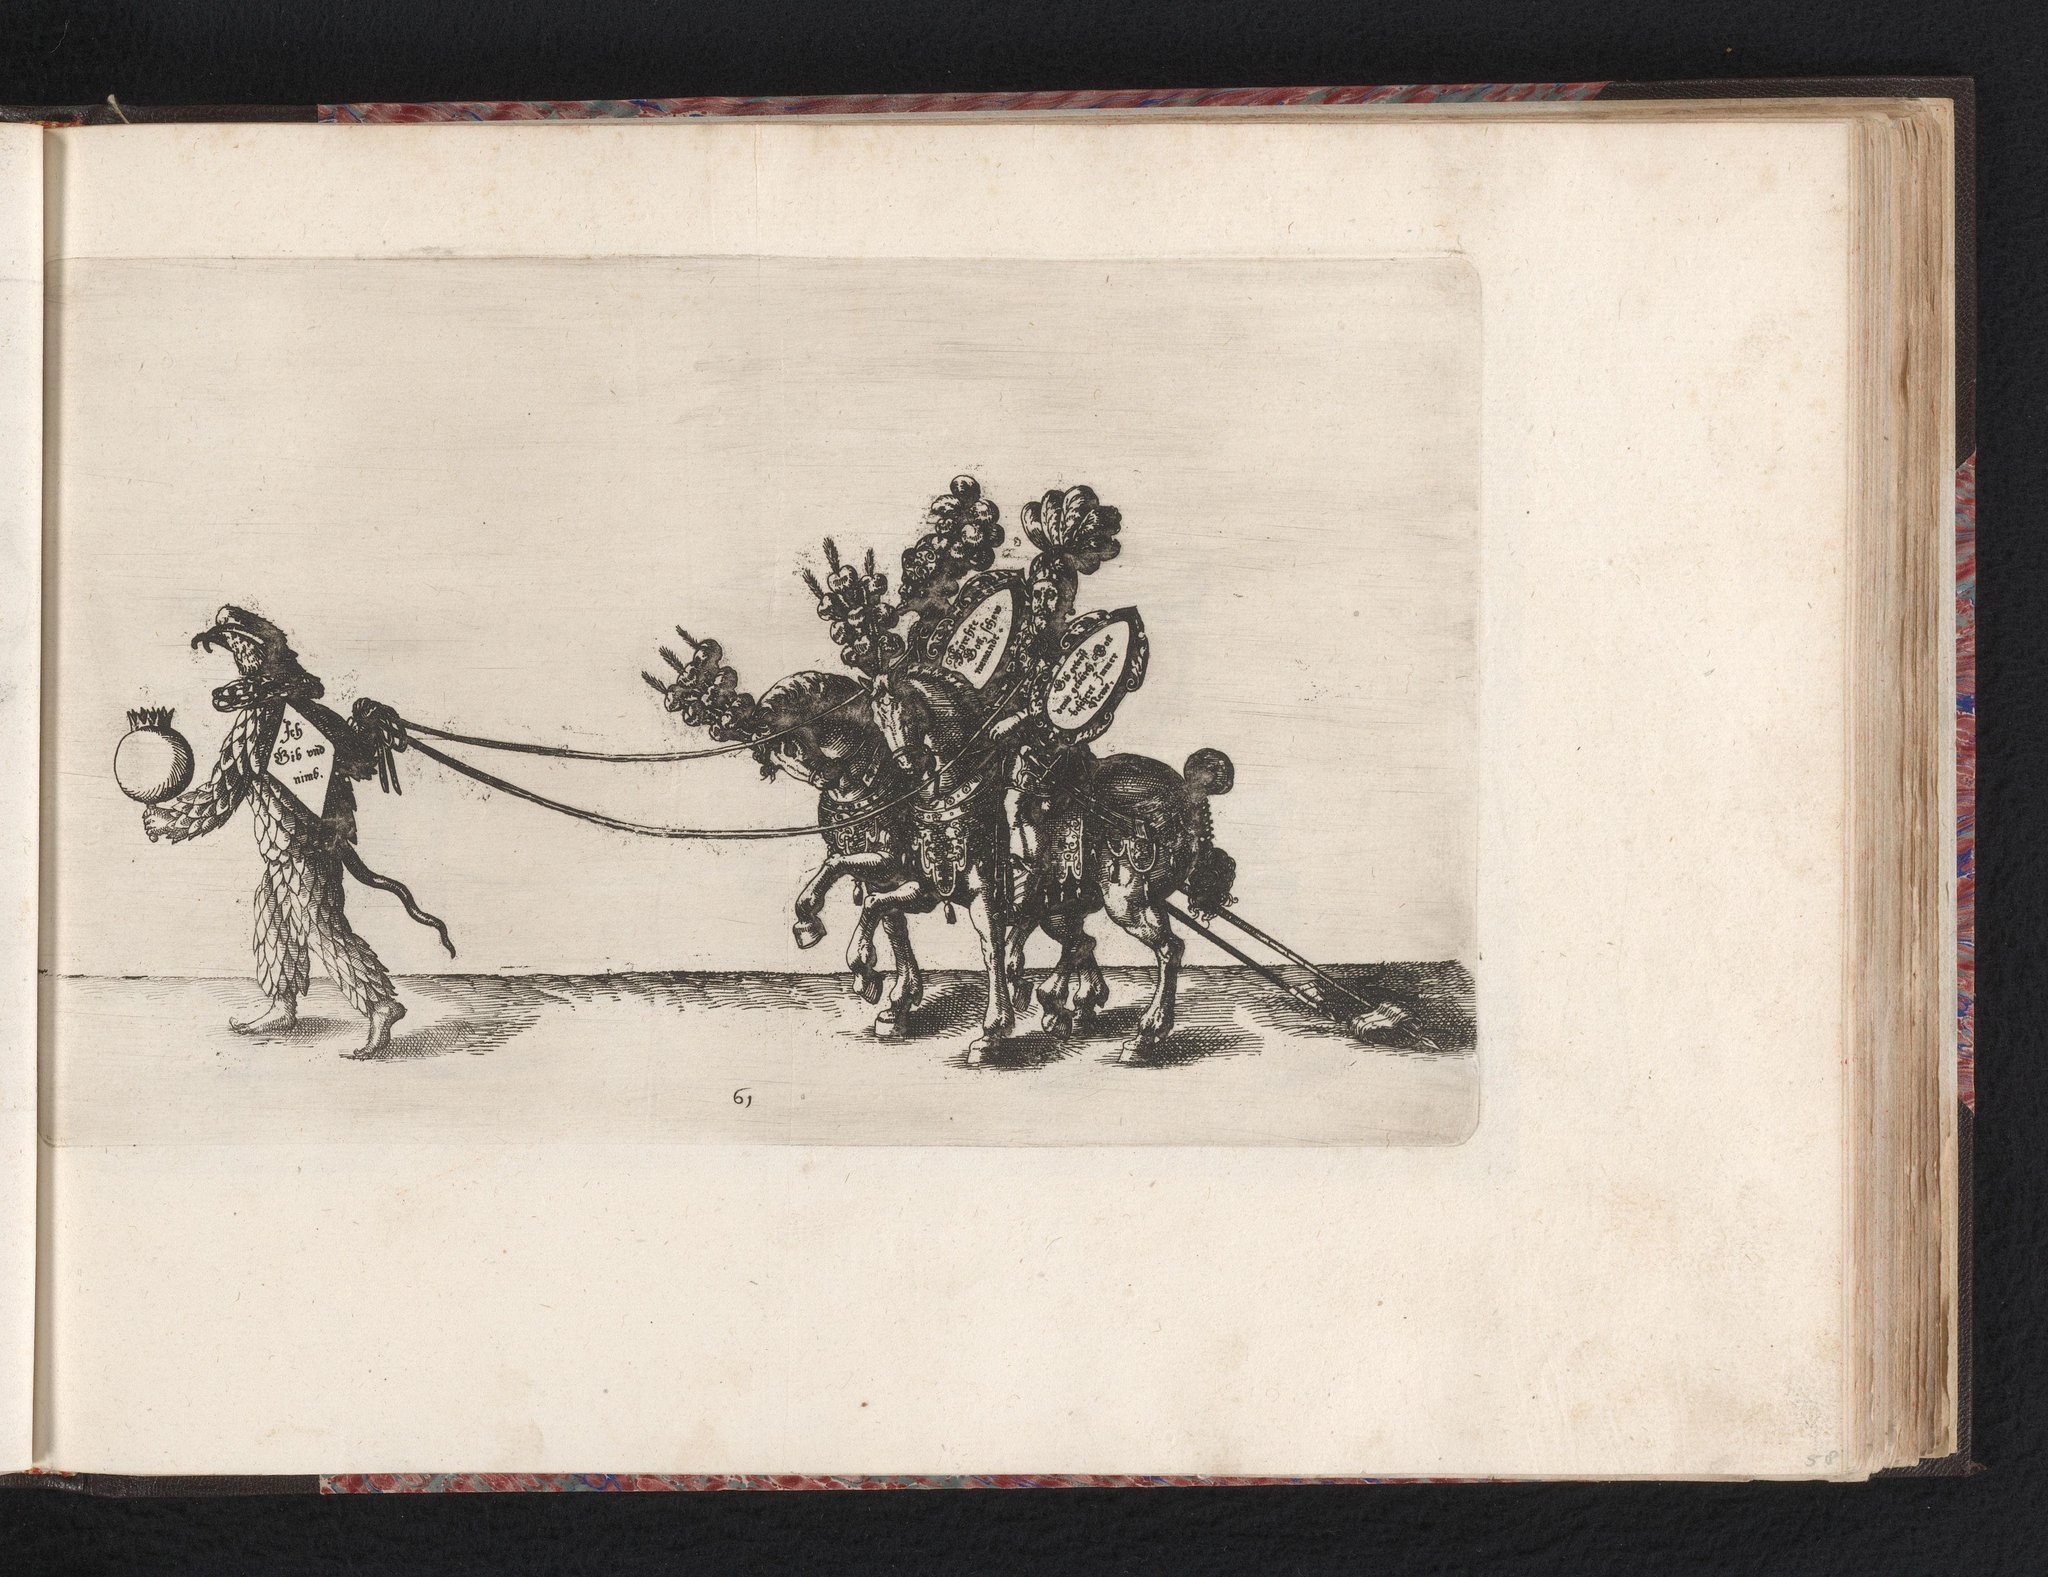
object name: print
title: Optochten en ruiterspelen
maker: friedrich brentel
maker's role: painter, print maker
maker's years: 1580-1651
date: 1618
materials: paper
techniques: etching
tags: mask, good and bad behaviour, moral qualities (opposing concepts), monsters of mixed human and animal shape; 'mostri' (ripa), performance in the open air (pleasure fair)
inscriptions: annotation: ‘60’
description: Tekst in het Duits op de geplakte strook en de ruggen van de geschubde figuren. Deze prent maakt deel uit van een album.